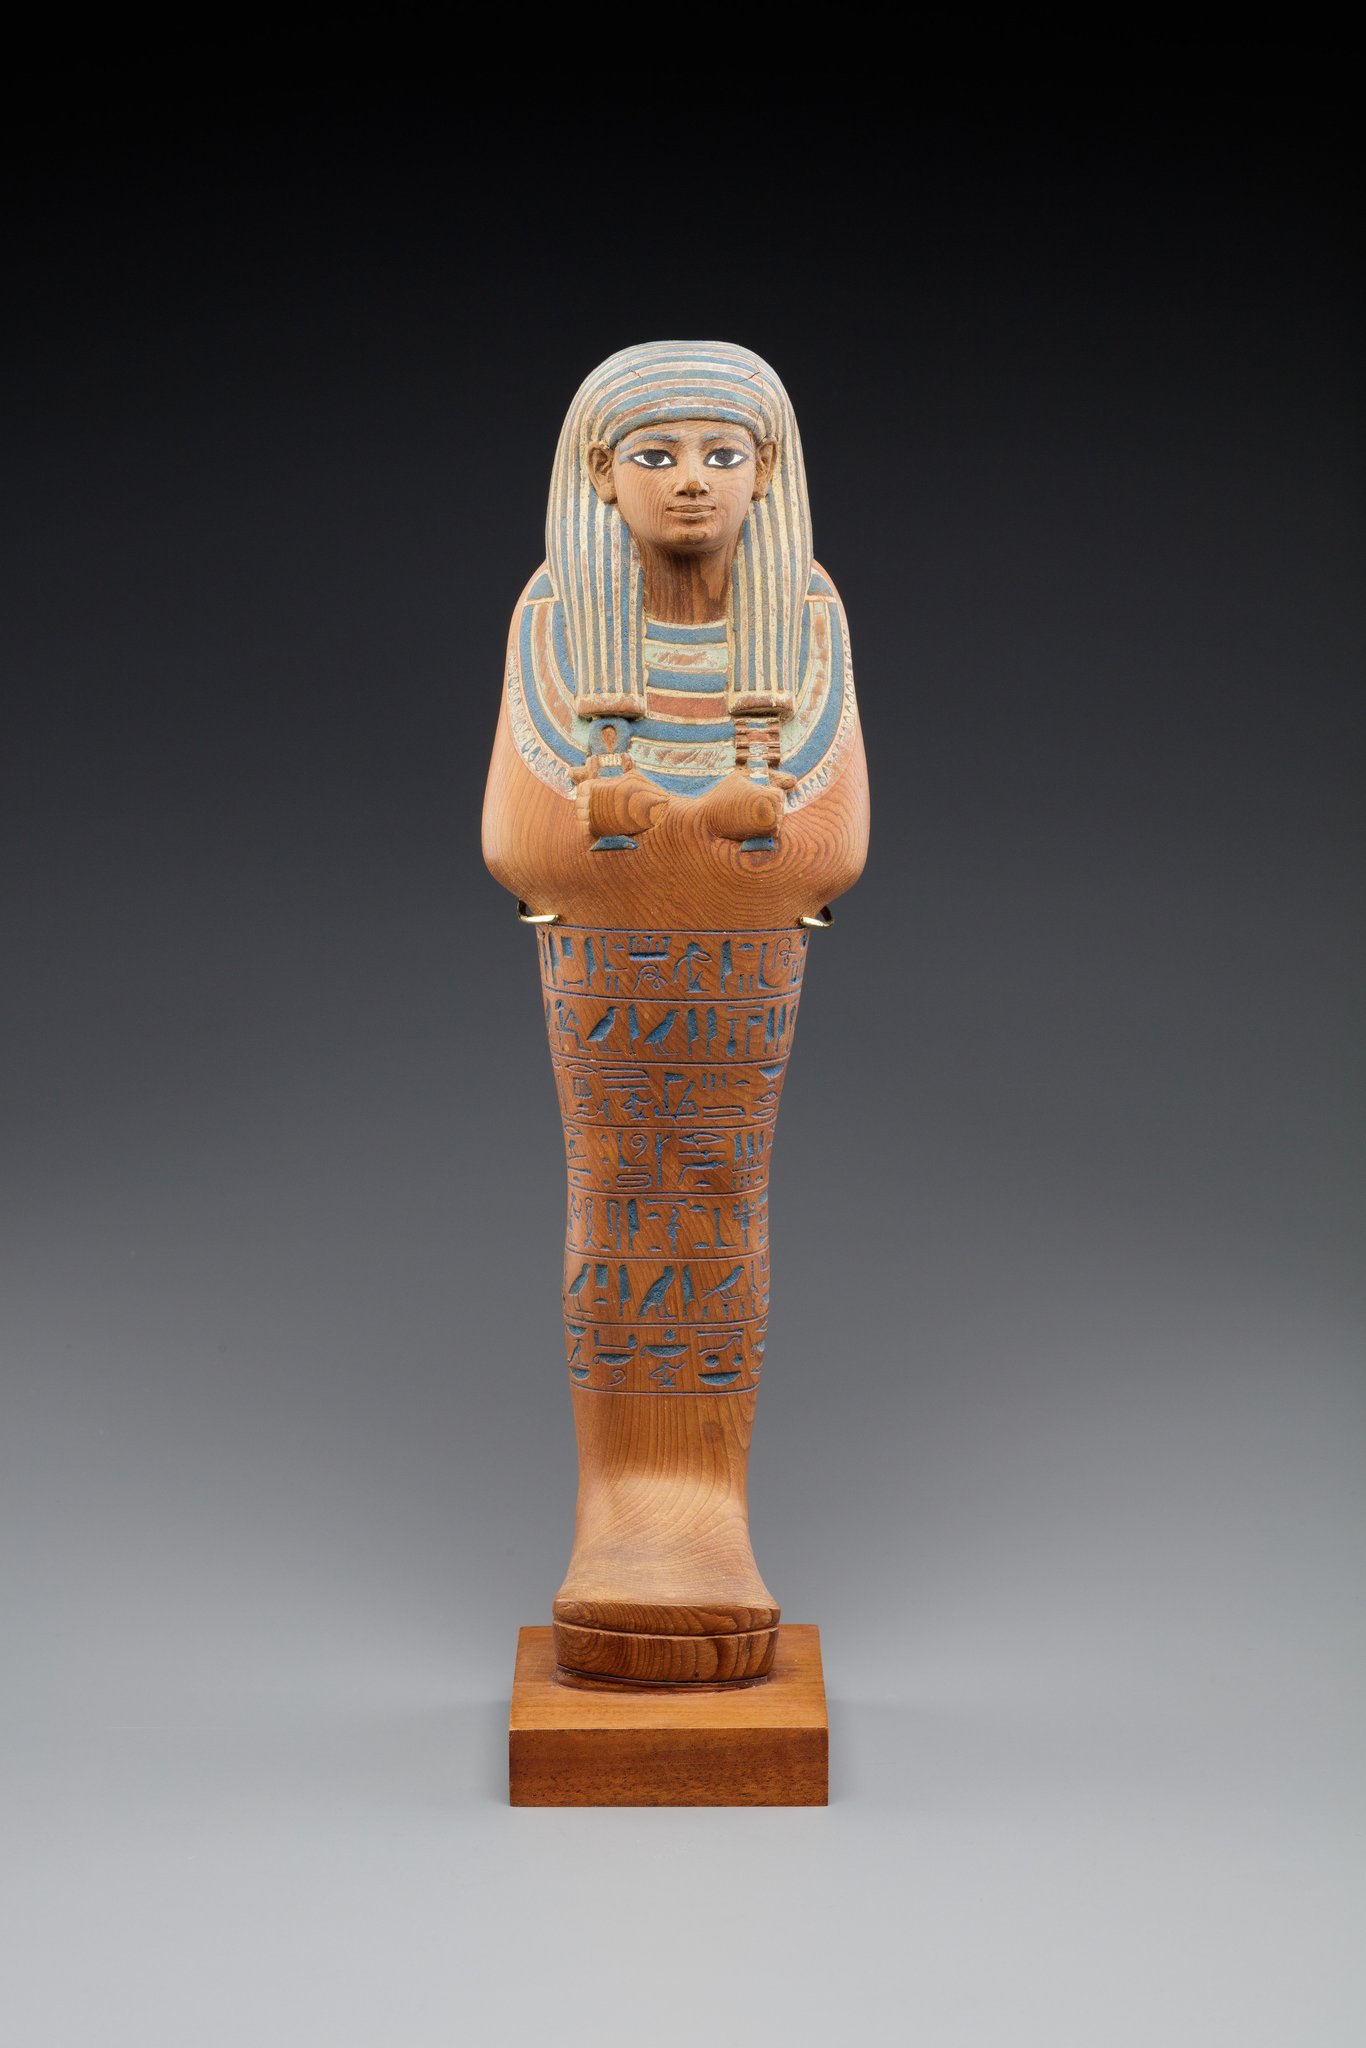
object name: shabti, yuya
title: Shabti of Yuya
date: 1390-1352 BCE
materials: wood, paint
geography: egypt